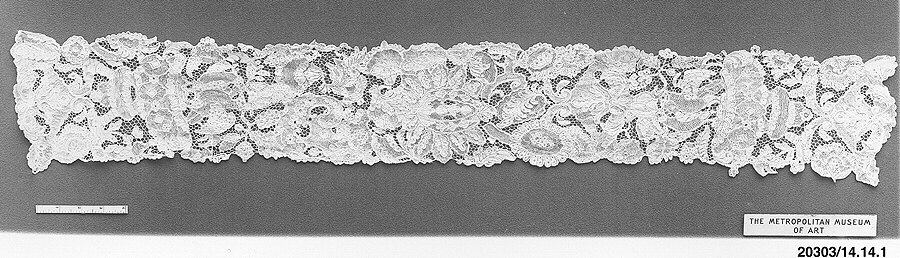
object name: barbe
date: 1715-1724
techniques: lace